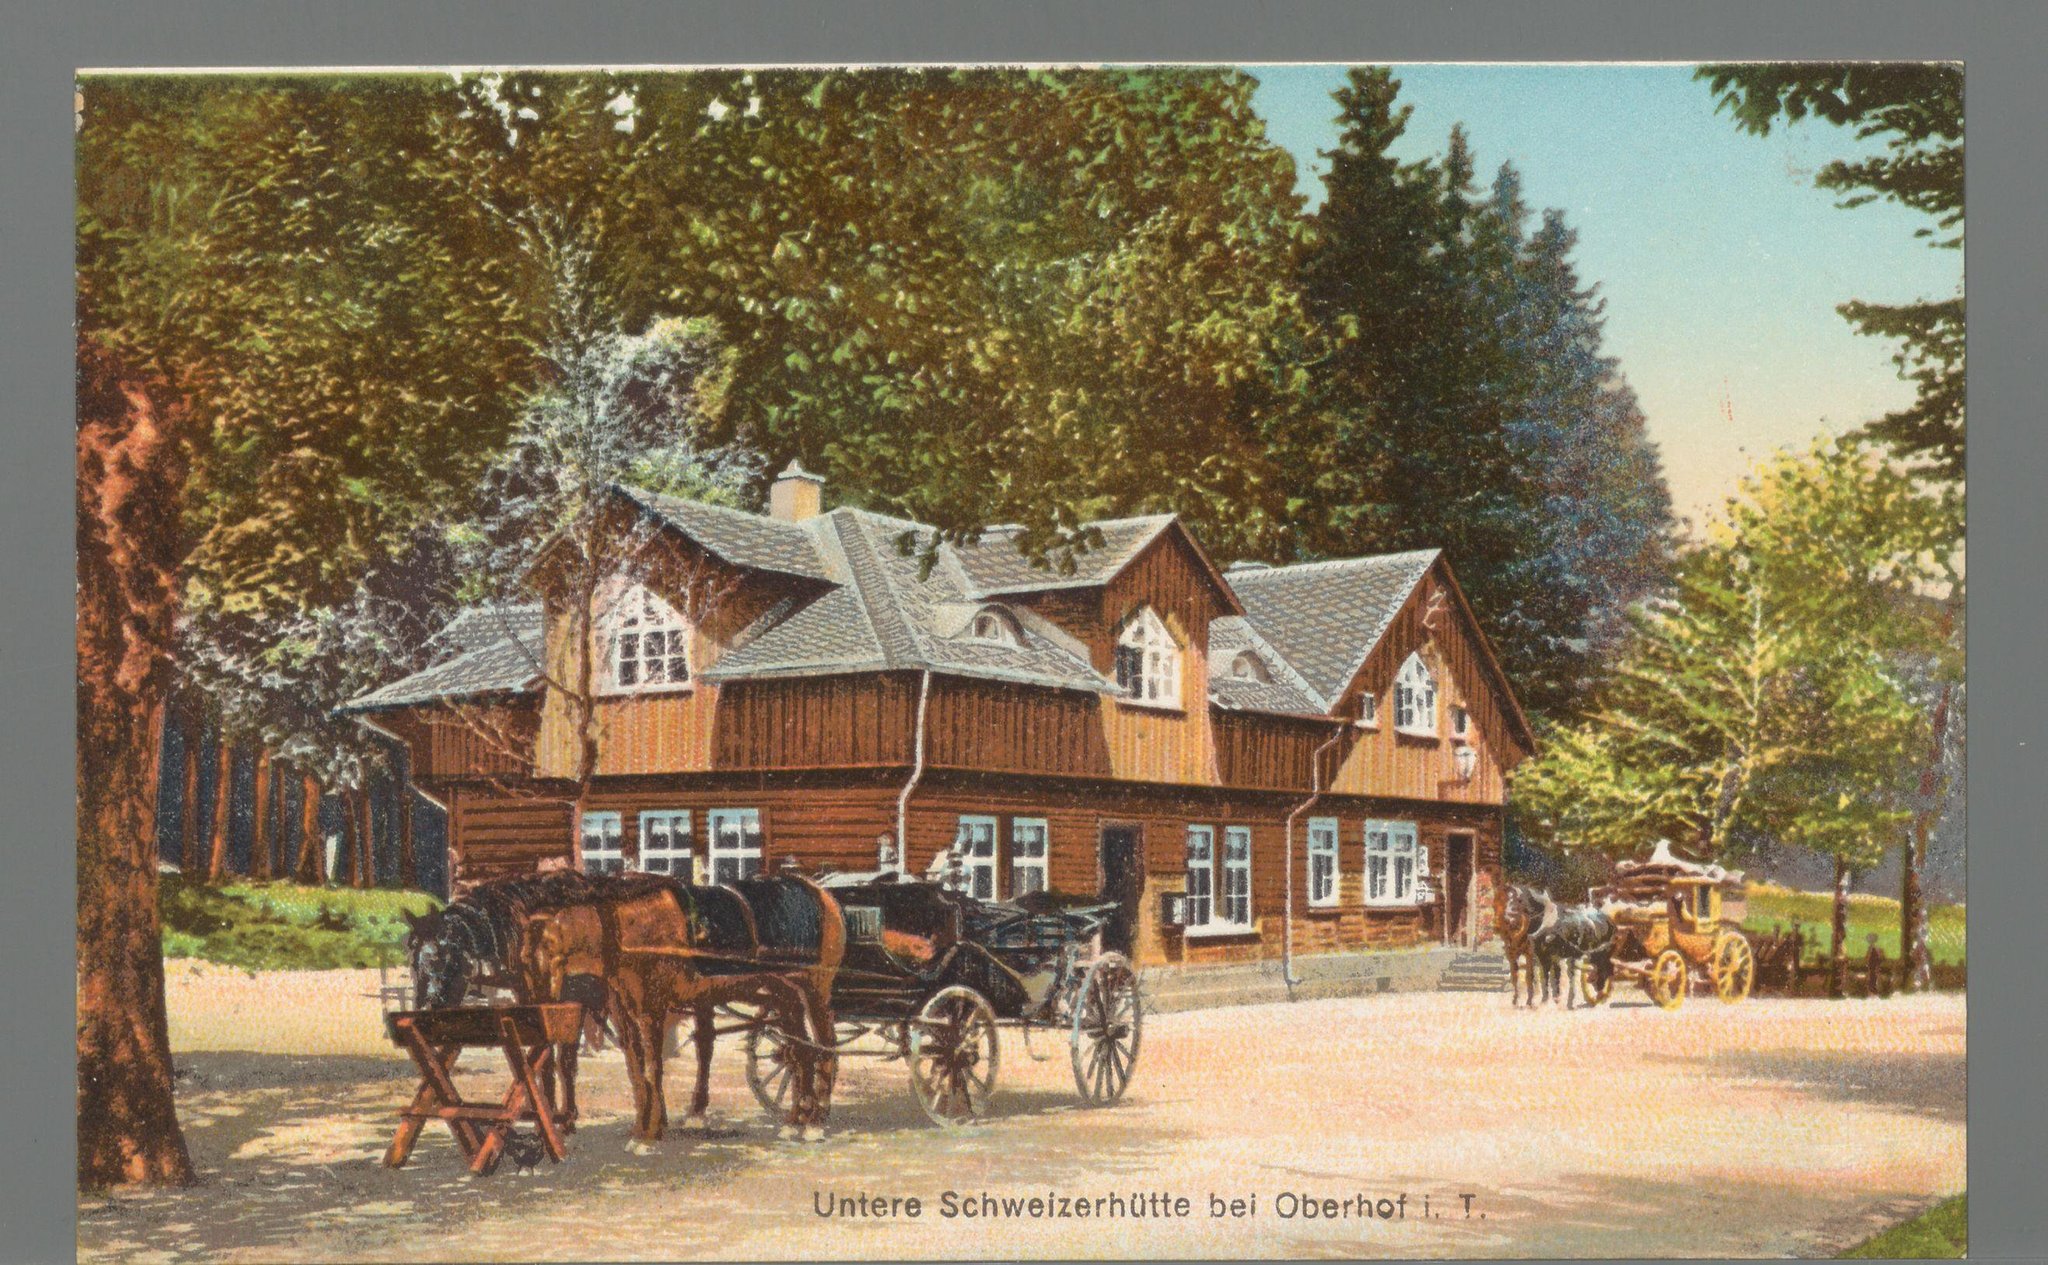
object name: print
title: Untere Schweizerhütte bei Oberhof i. T.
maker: Anonymous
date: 1910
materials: cardboard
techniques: lithograph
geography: oberhof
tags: villa, four-wheeled vehicle drawn by two animals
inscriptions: date